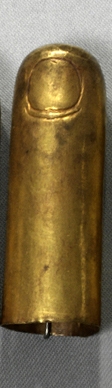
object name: finger stall, group 2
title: Finger stall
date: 1479-1425 BCE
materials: gold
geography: egypt